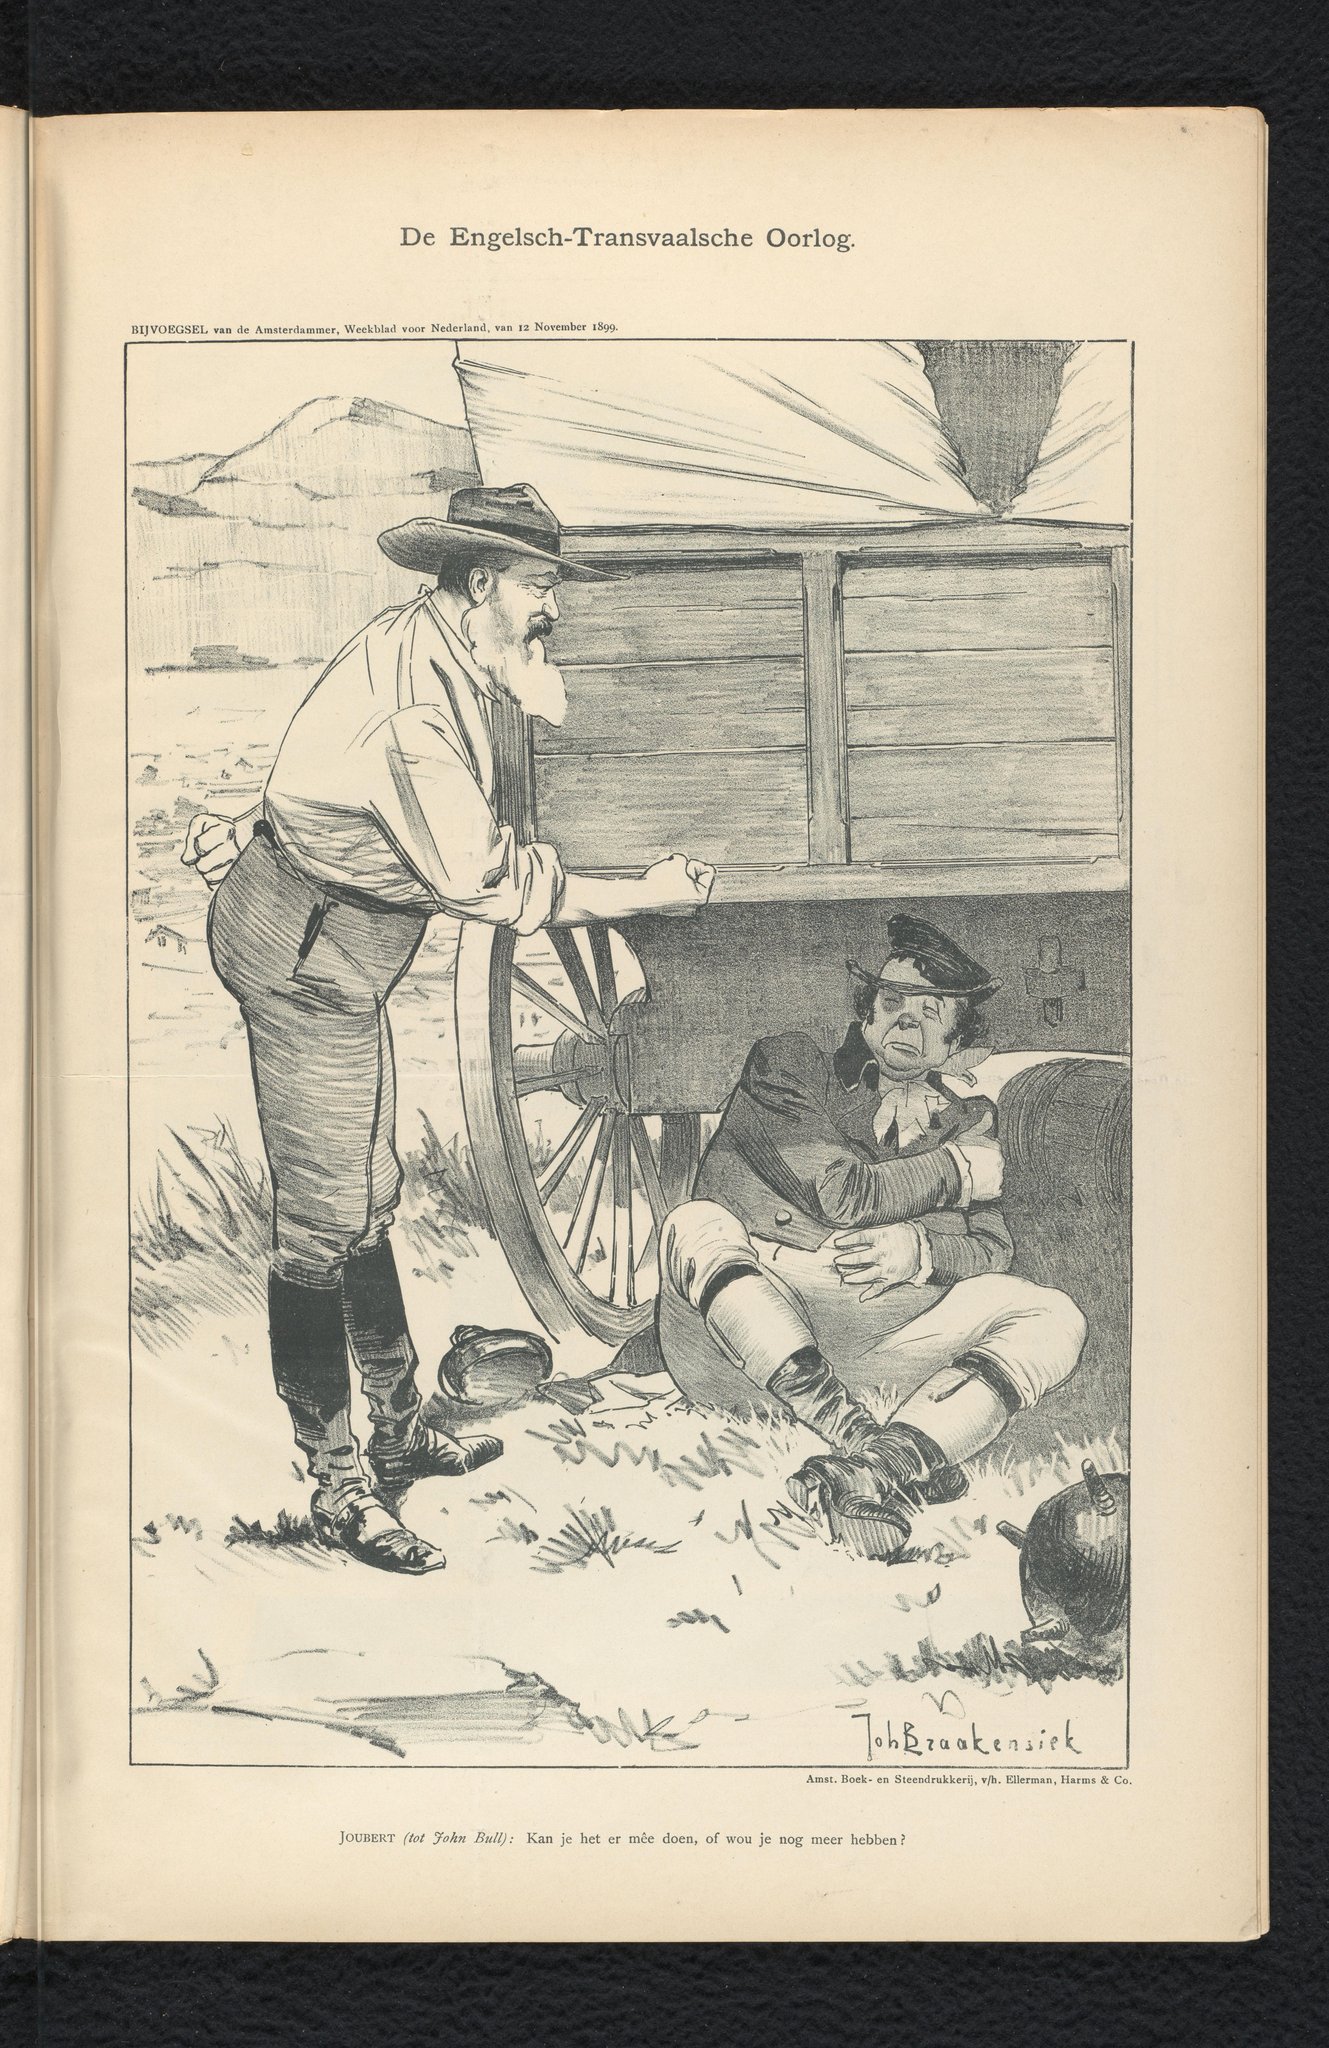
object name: cartoon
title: Den Engelsch-Transvaalsche Oorlog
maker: johan braakensiek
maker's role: draughtsman, print maker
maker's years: 1858-1940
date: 1899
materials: paper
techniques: lithograph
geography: amsterdam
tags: politician, personifications of countries, nations, states, districts, etc., the defeated (after the battle), political caricatures and satires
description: Piet Joubert, de militaire leider van de Boeren in Transvaal, informeert bij de op de grond onder een huifkar zittende toegetakelde John Bull of hij nog meer slaag wil hebben.